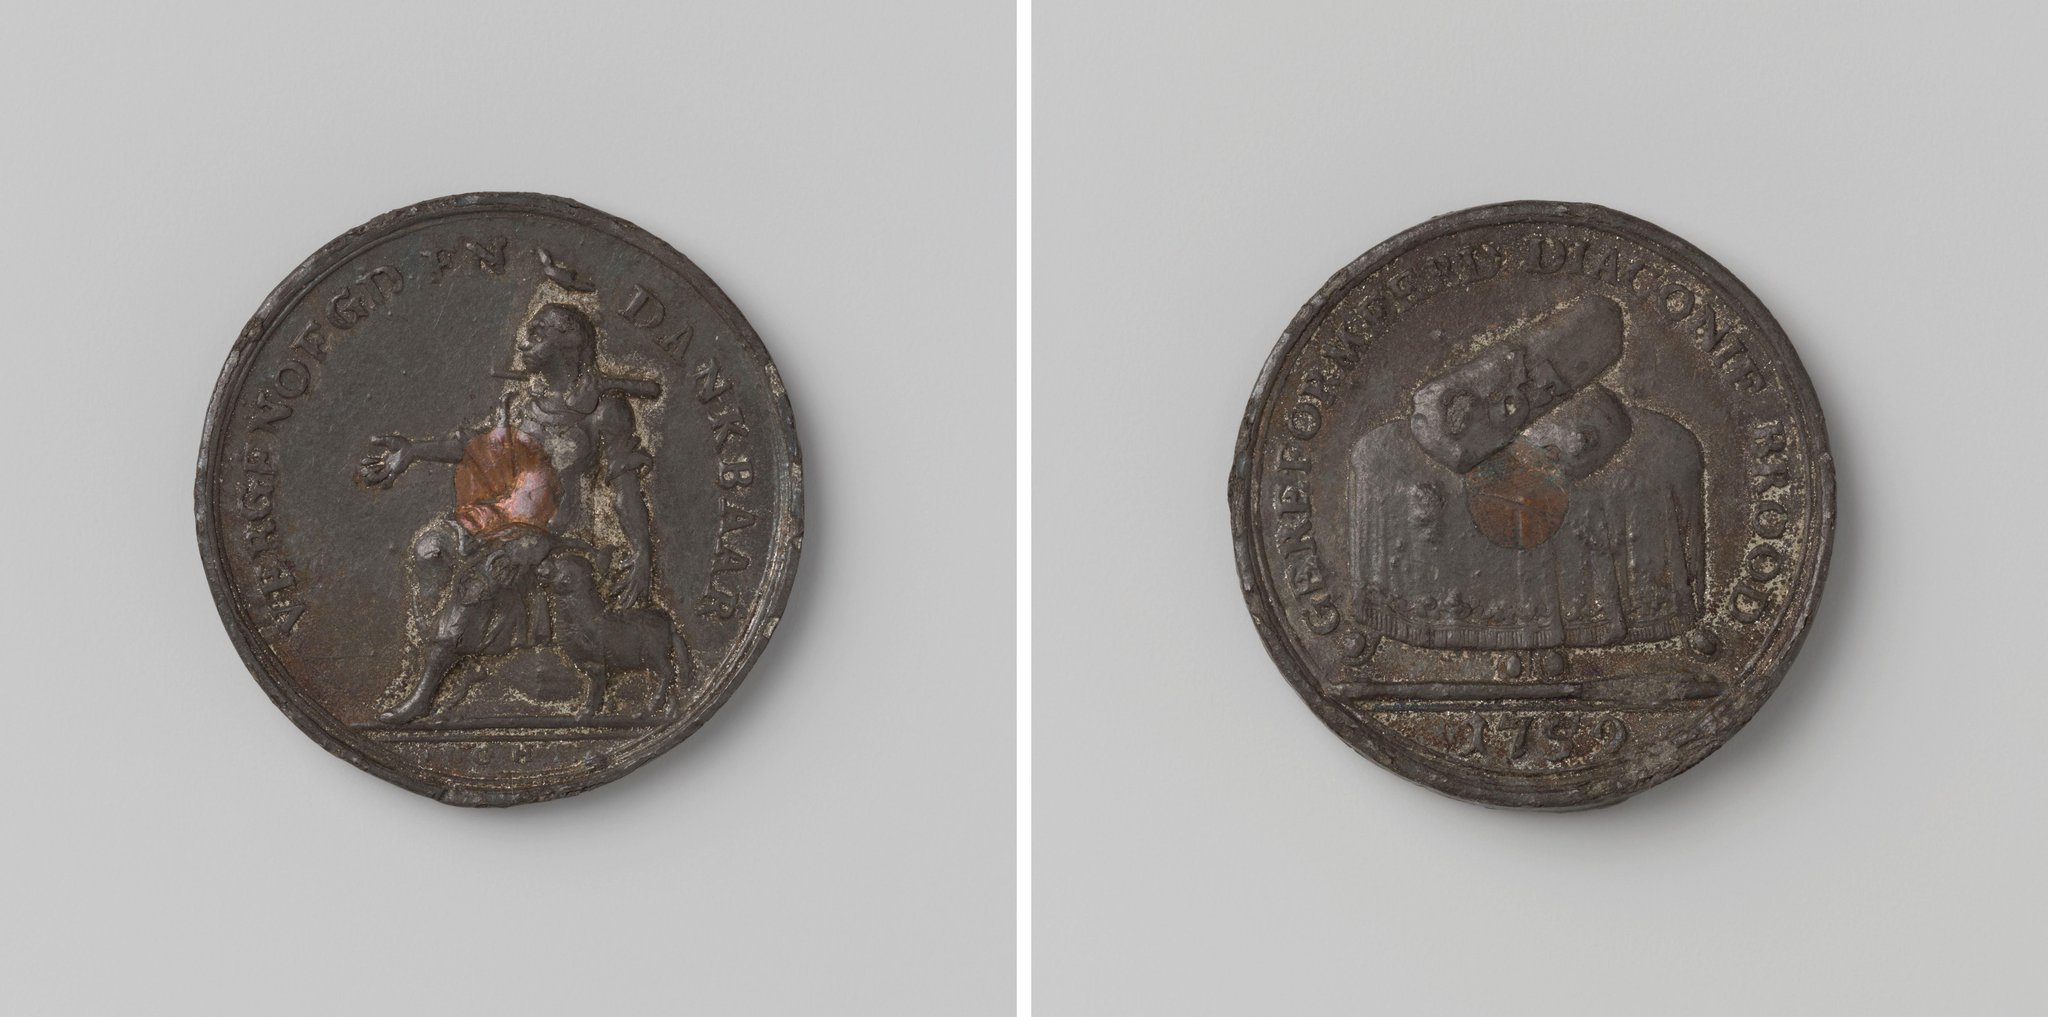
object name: alms token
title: Gereformeerde Diakonie te Amsterdam, armenpenning die behoeftige kerklidmaten bij uitdeling recht gaf op brood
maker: johan george holtzhey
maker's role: mintmaster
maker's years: 1726-1808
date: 1759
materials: copper, lead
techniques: striking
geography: amsterdam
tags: amsterdam